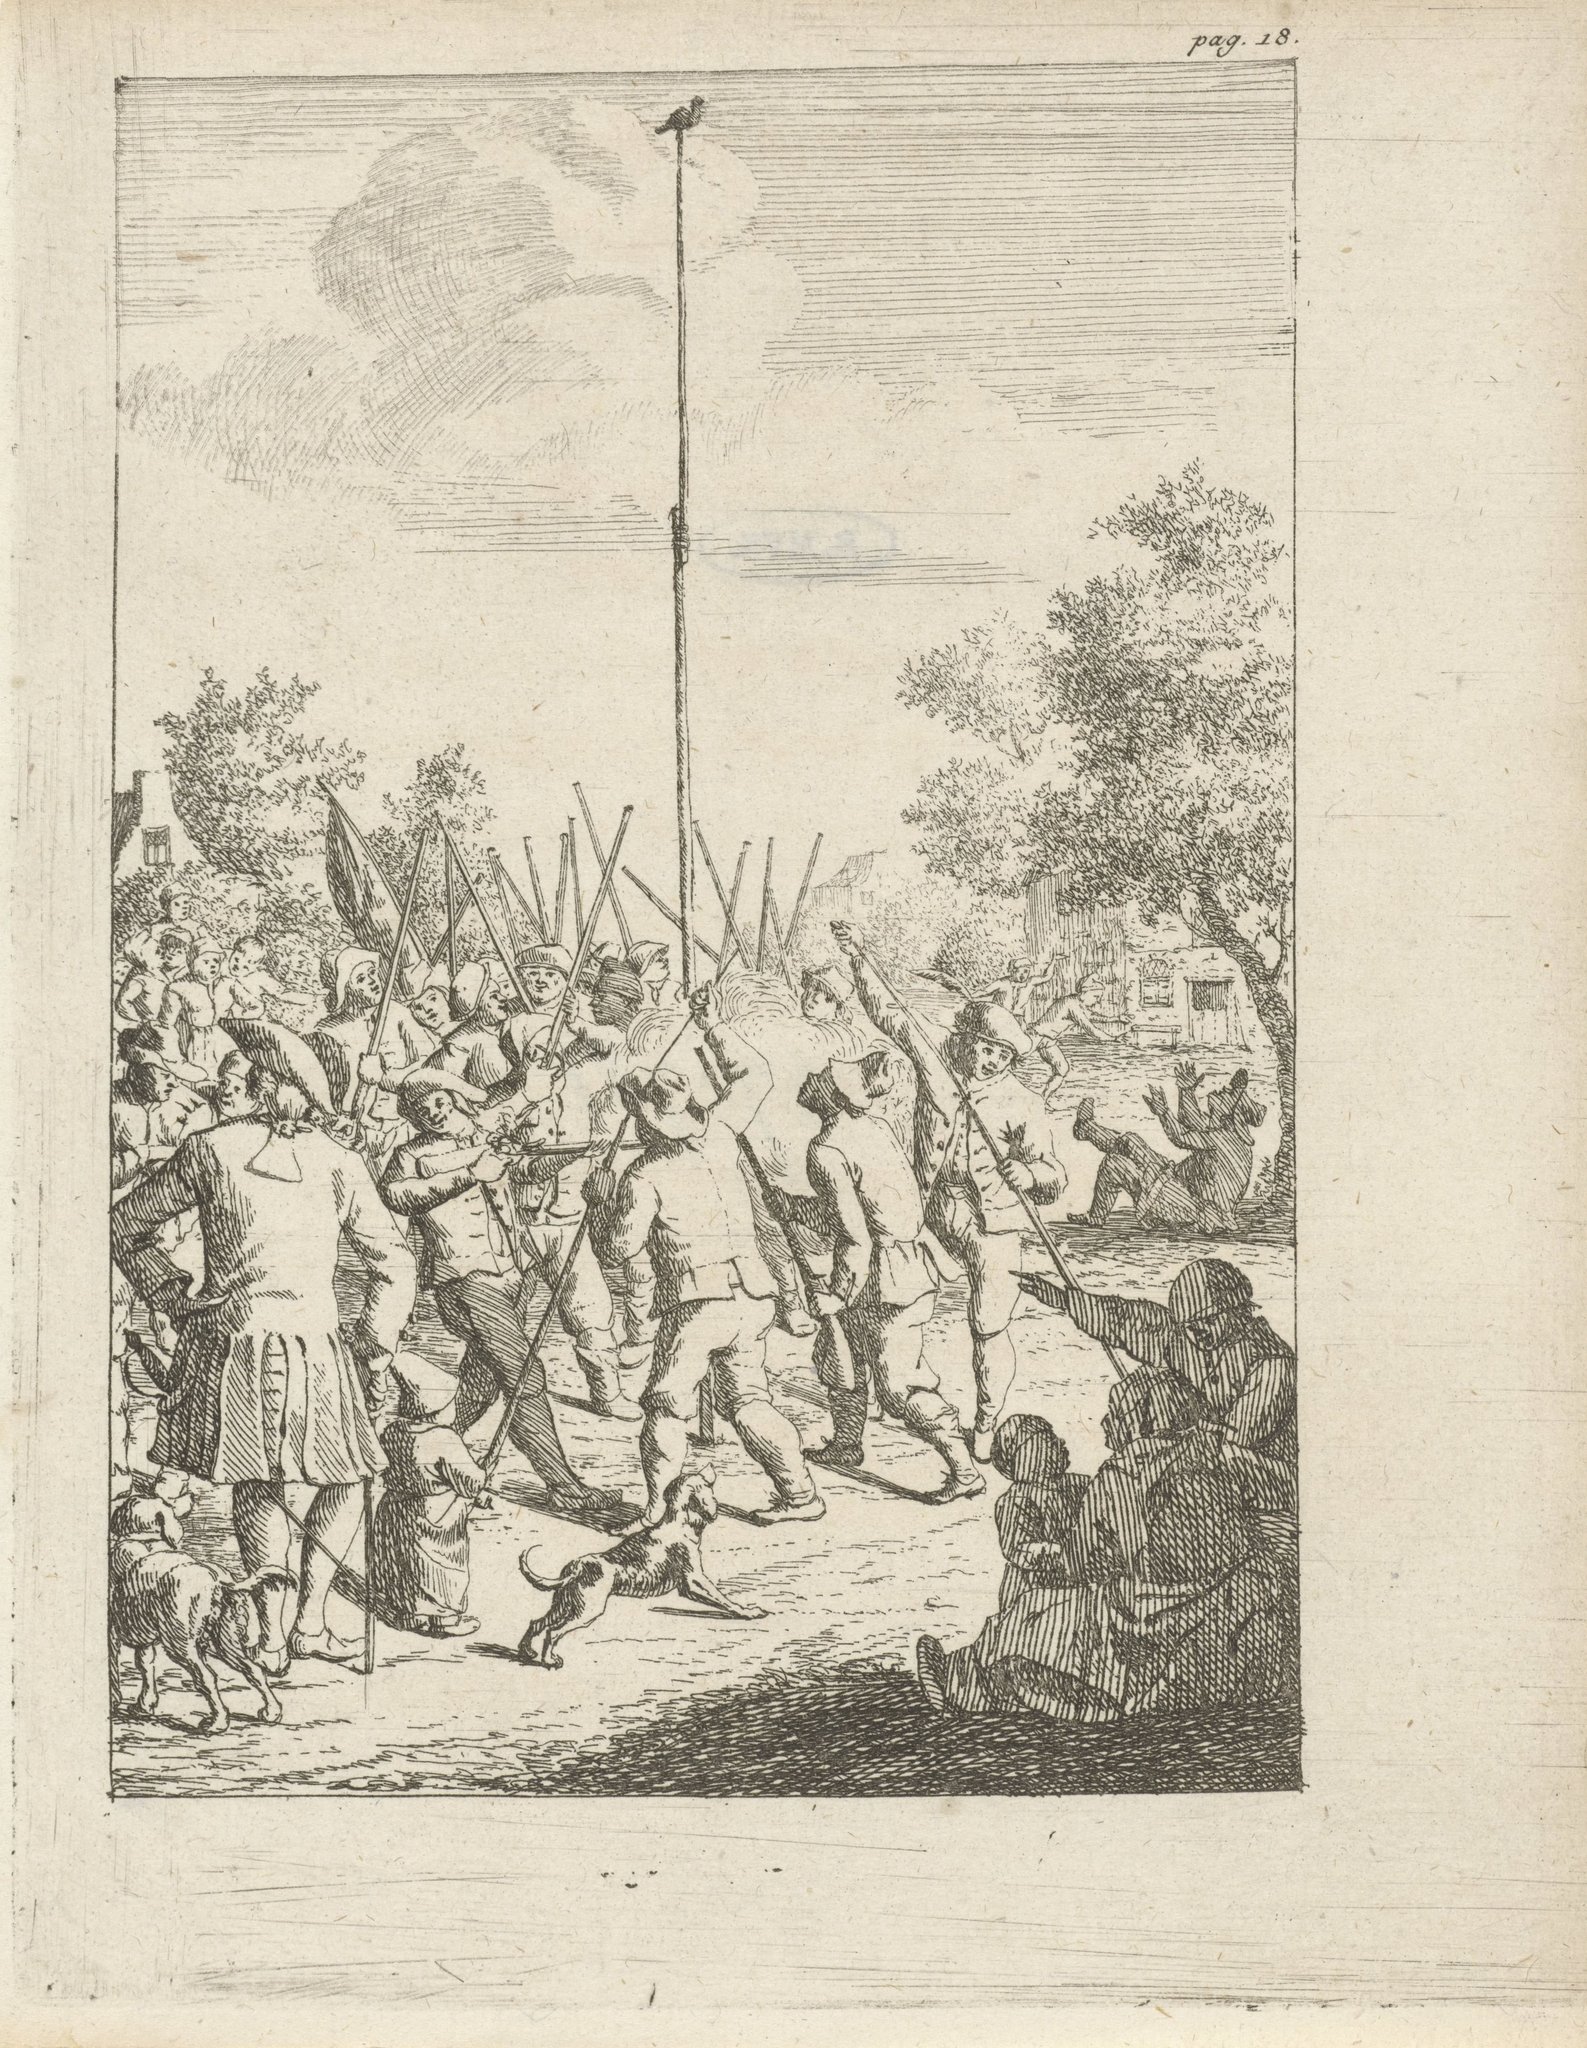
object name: print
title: Vogelschieten op een schuttersfeest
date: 1733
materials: paper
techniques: etching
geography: rotterdam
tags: farmers, pleasure fair and circus, shooting-the-bird (on a high pole)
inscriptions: collector's mark: Lugt 2760, collector's mark: Lugt 2228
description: Verschillende schutters trachten met hun geweren een houten vogel van een paal te schieten. Rondom hen kijken mannen, vrouwen en kinderen toe.